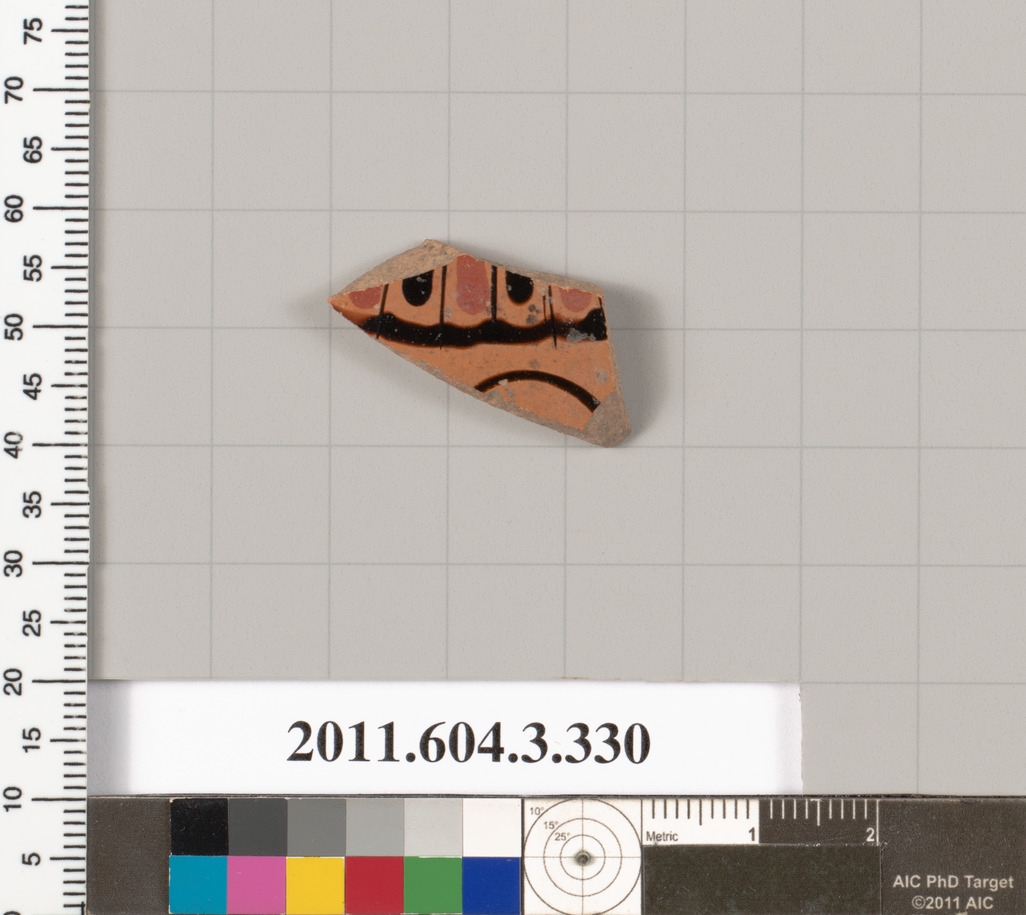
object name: neck amphora fragment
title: Terracotta fragment of a neck-amphora (jar)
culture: greek, attic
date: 540-520 BCE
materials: terracotta